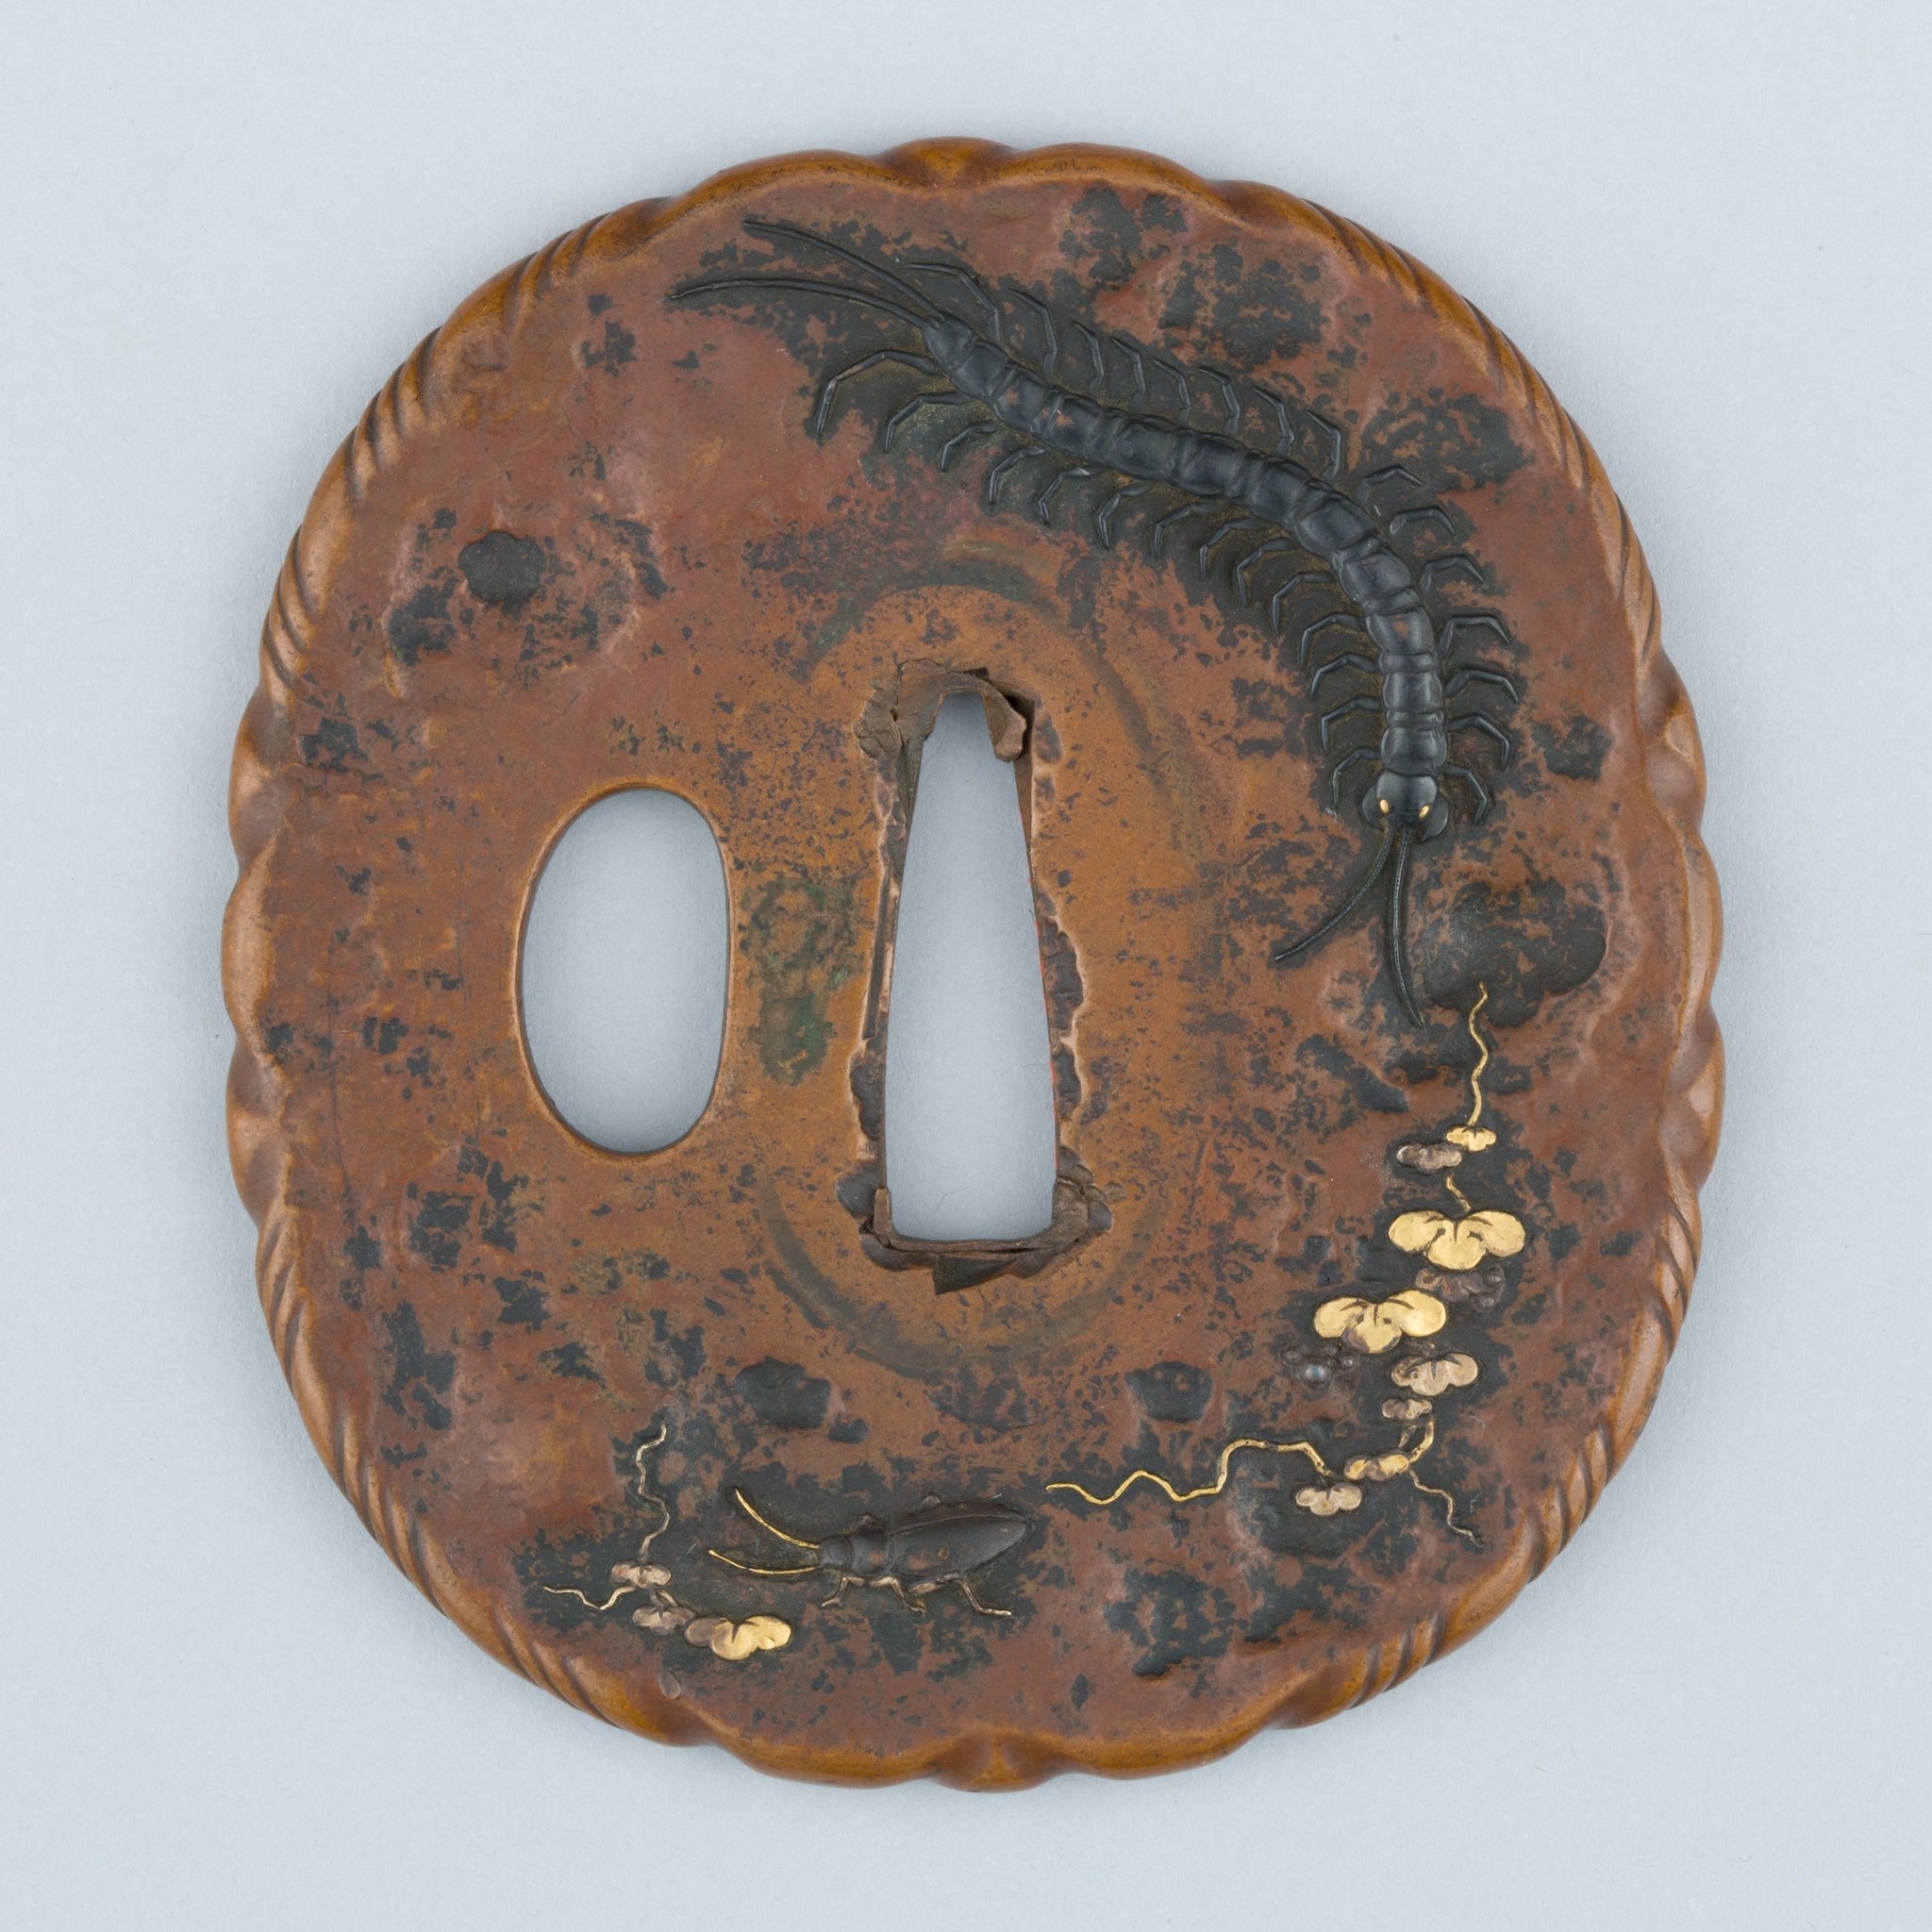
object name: sword guard tsuba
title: Sword Guard (Tsuba)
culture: japanese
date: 1615-1868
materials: copper, gold alloy, gold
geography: japan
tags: insects